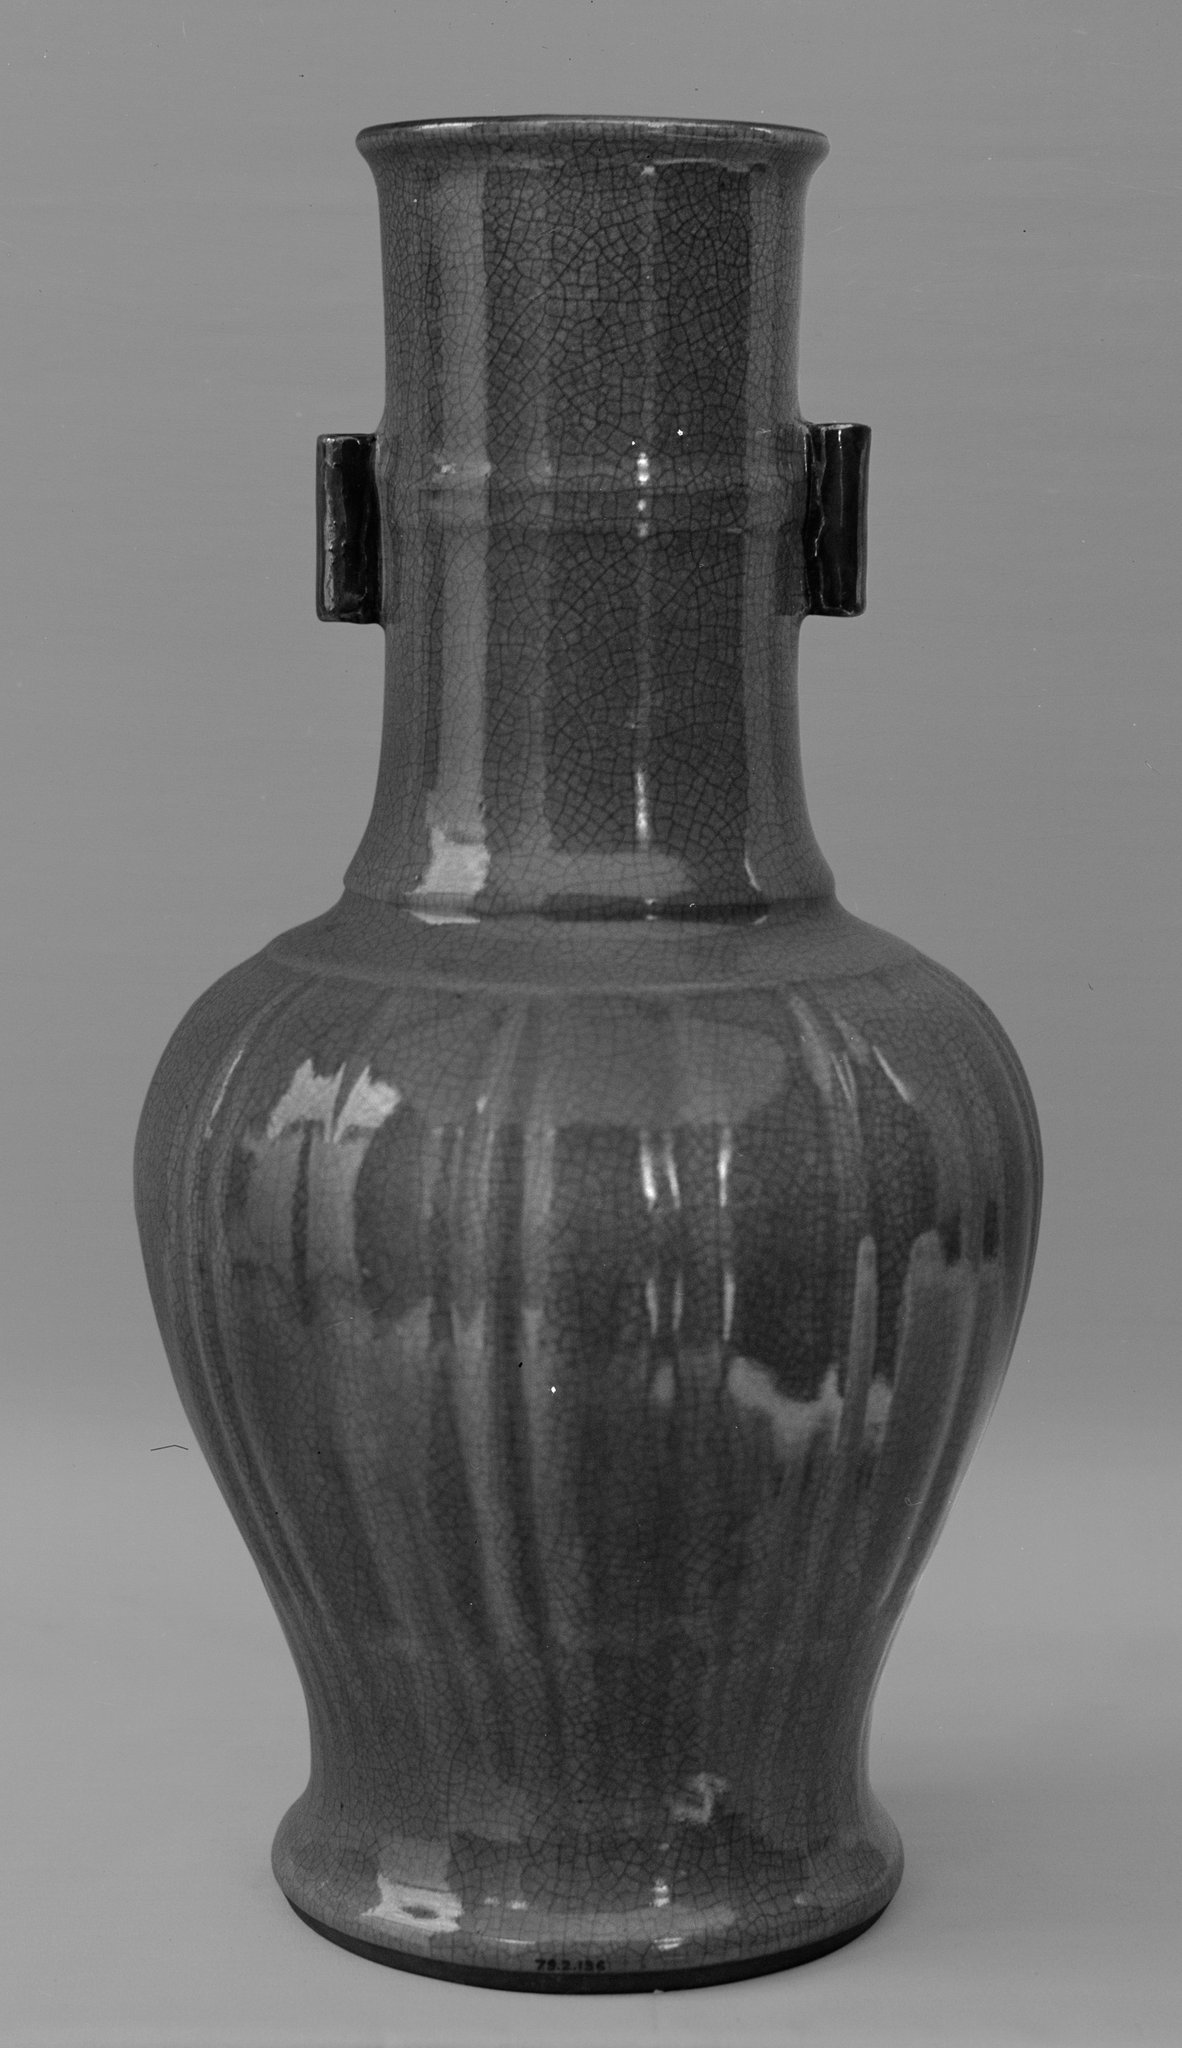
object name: vase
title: Vase with handles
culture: chinese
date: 1767-1900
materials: glaze, porcelain